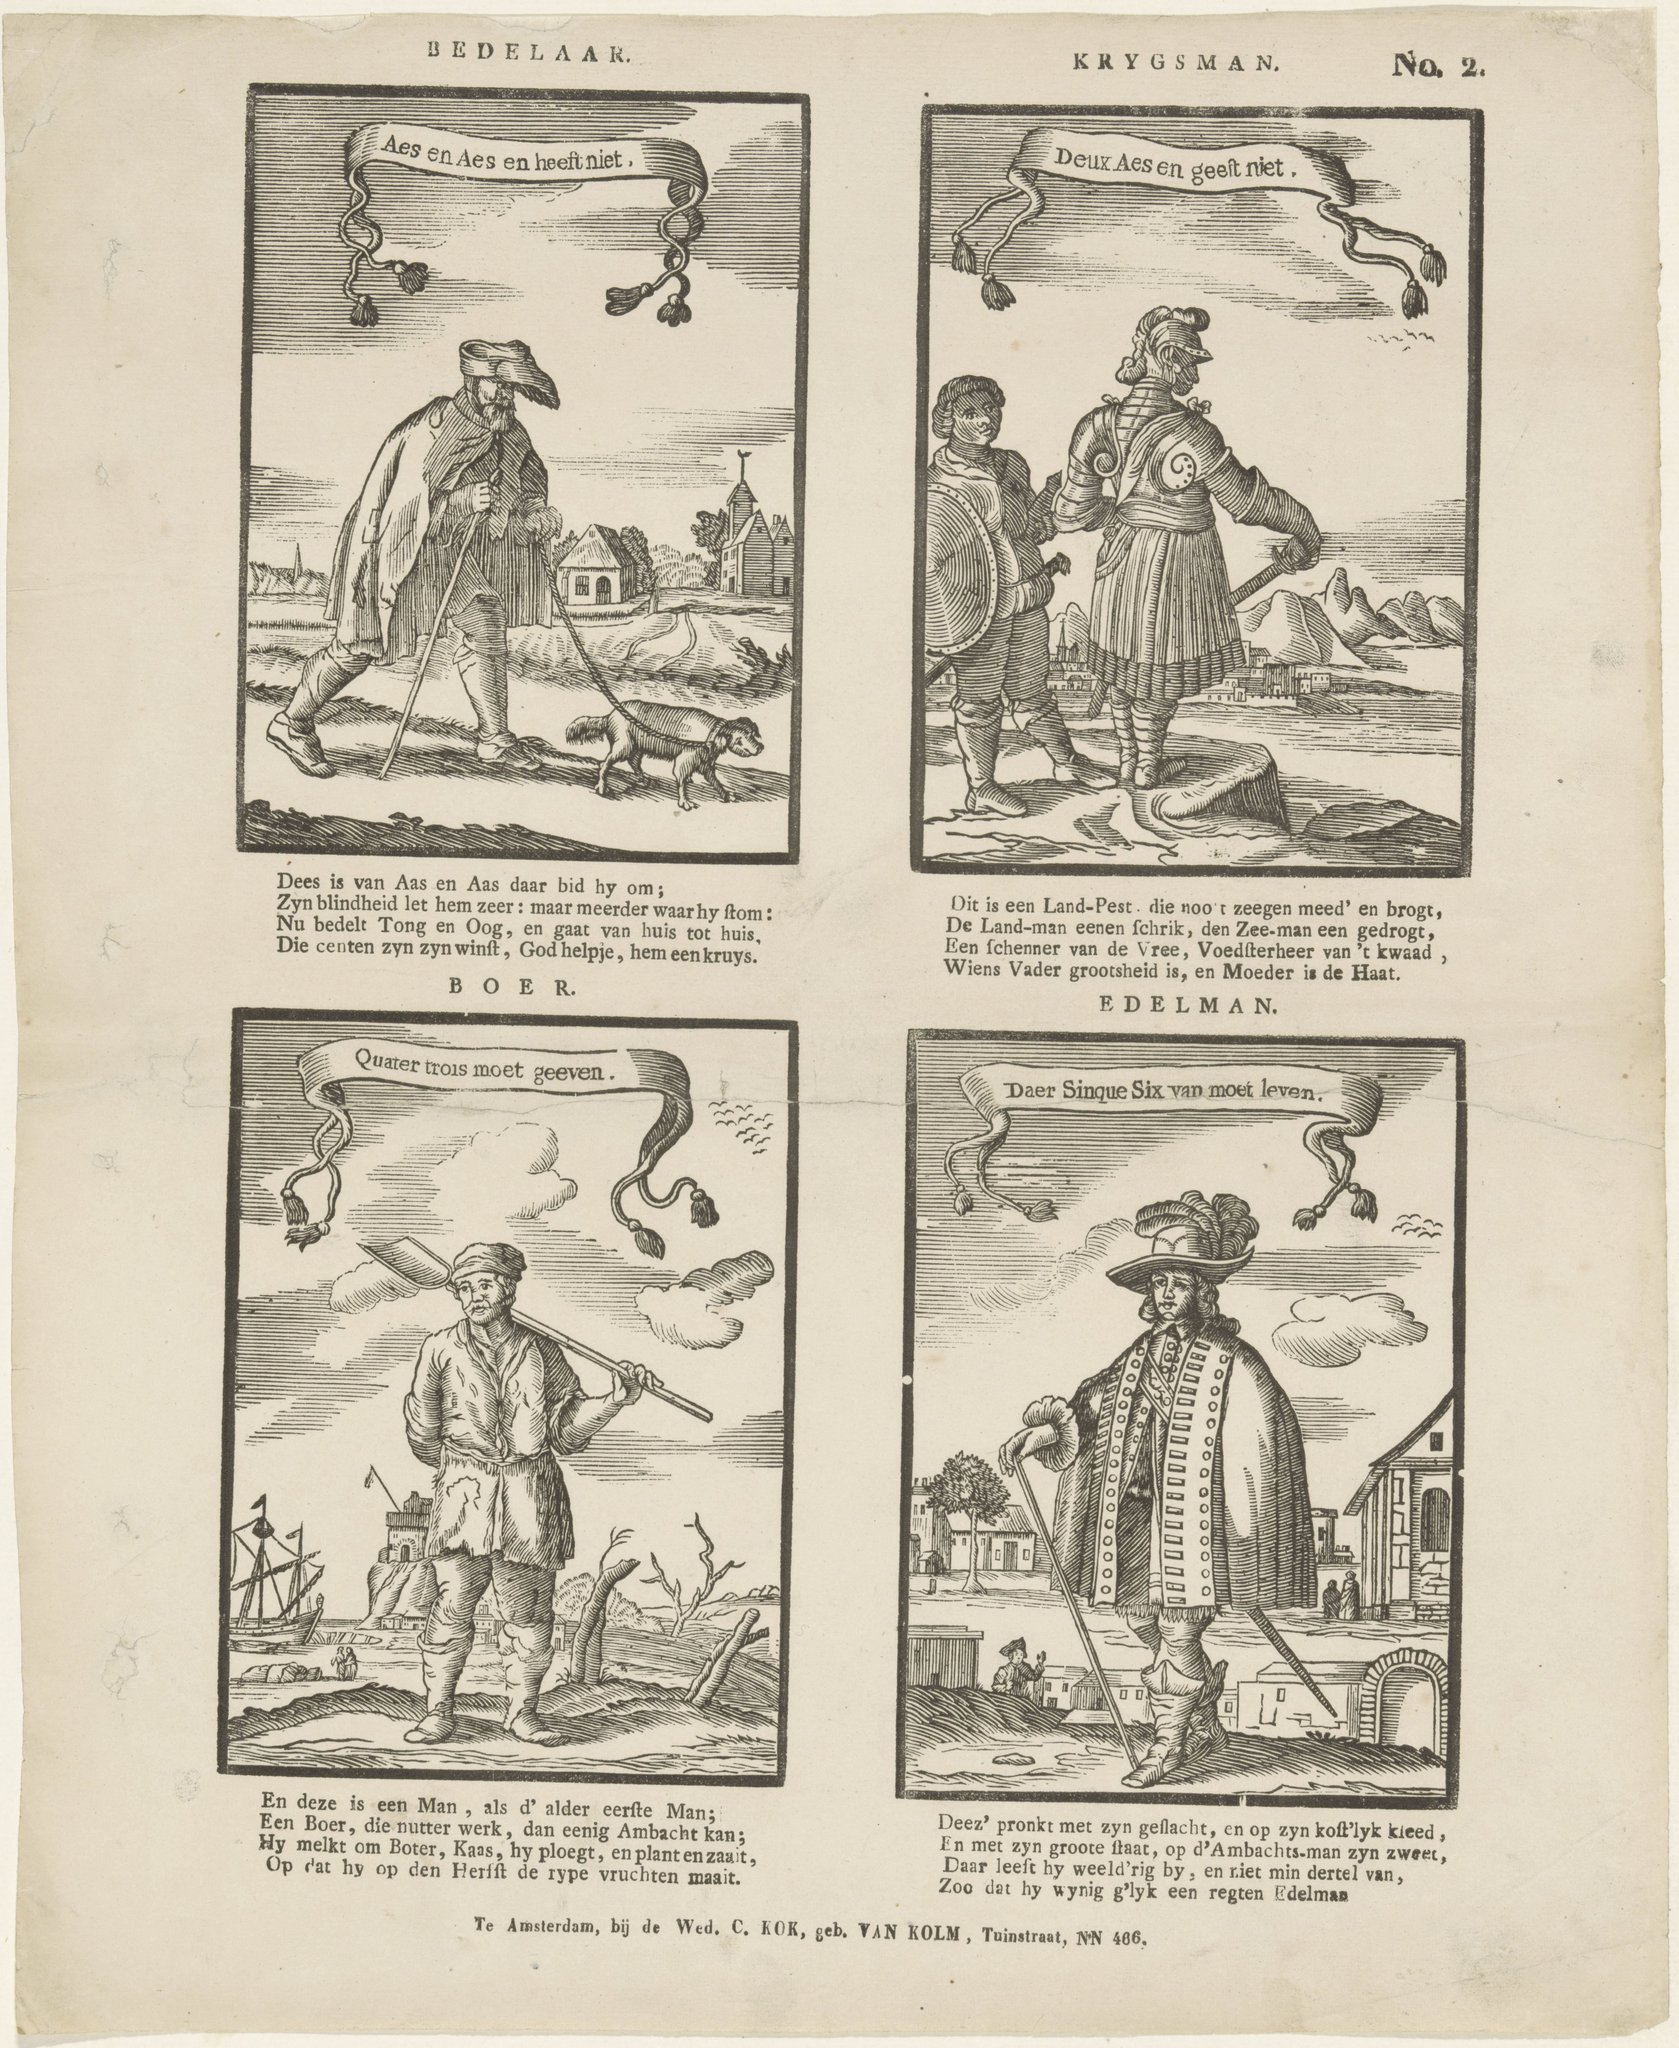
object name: popular print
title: Bedelaar. / Krygsman. / Boer. / Edelman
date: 1842-1866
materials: paper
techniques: letterpress printing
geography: amsterdam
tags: social position, farmers, the soldier; the soldier's life, beggar, nobility and patriciate; chivalry, knighthood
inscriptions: collector's mark: Lugt 2760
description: Blad met 4 voorstellingen van een bedelaar, een soldaat, een boer en een edelman (de vier standen). Boven elk figuur een banderol met tekst. Onder elke afbeelding een vierregelig vers. Genummerd rechtsboven: No. 2.